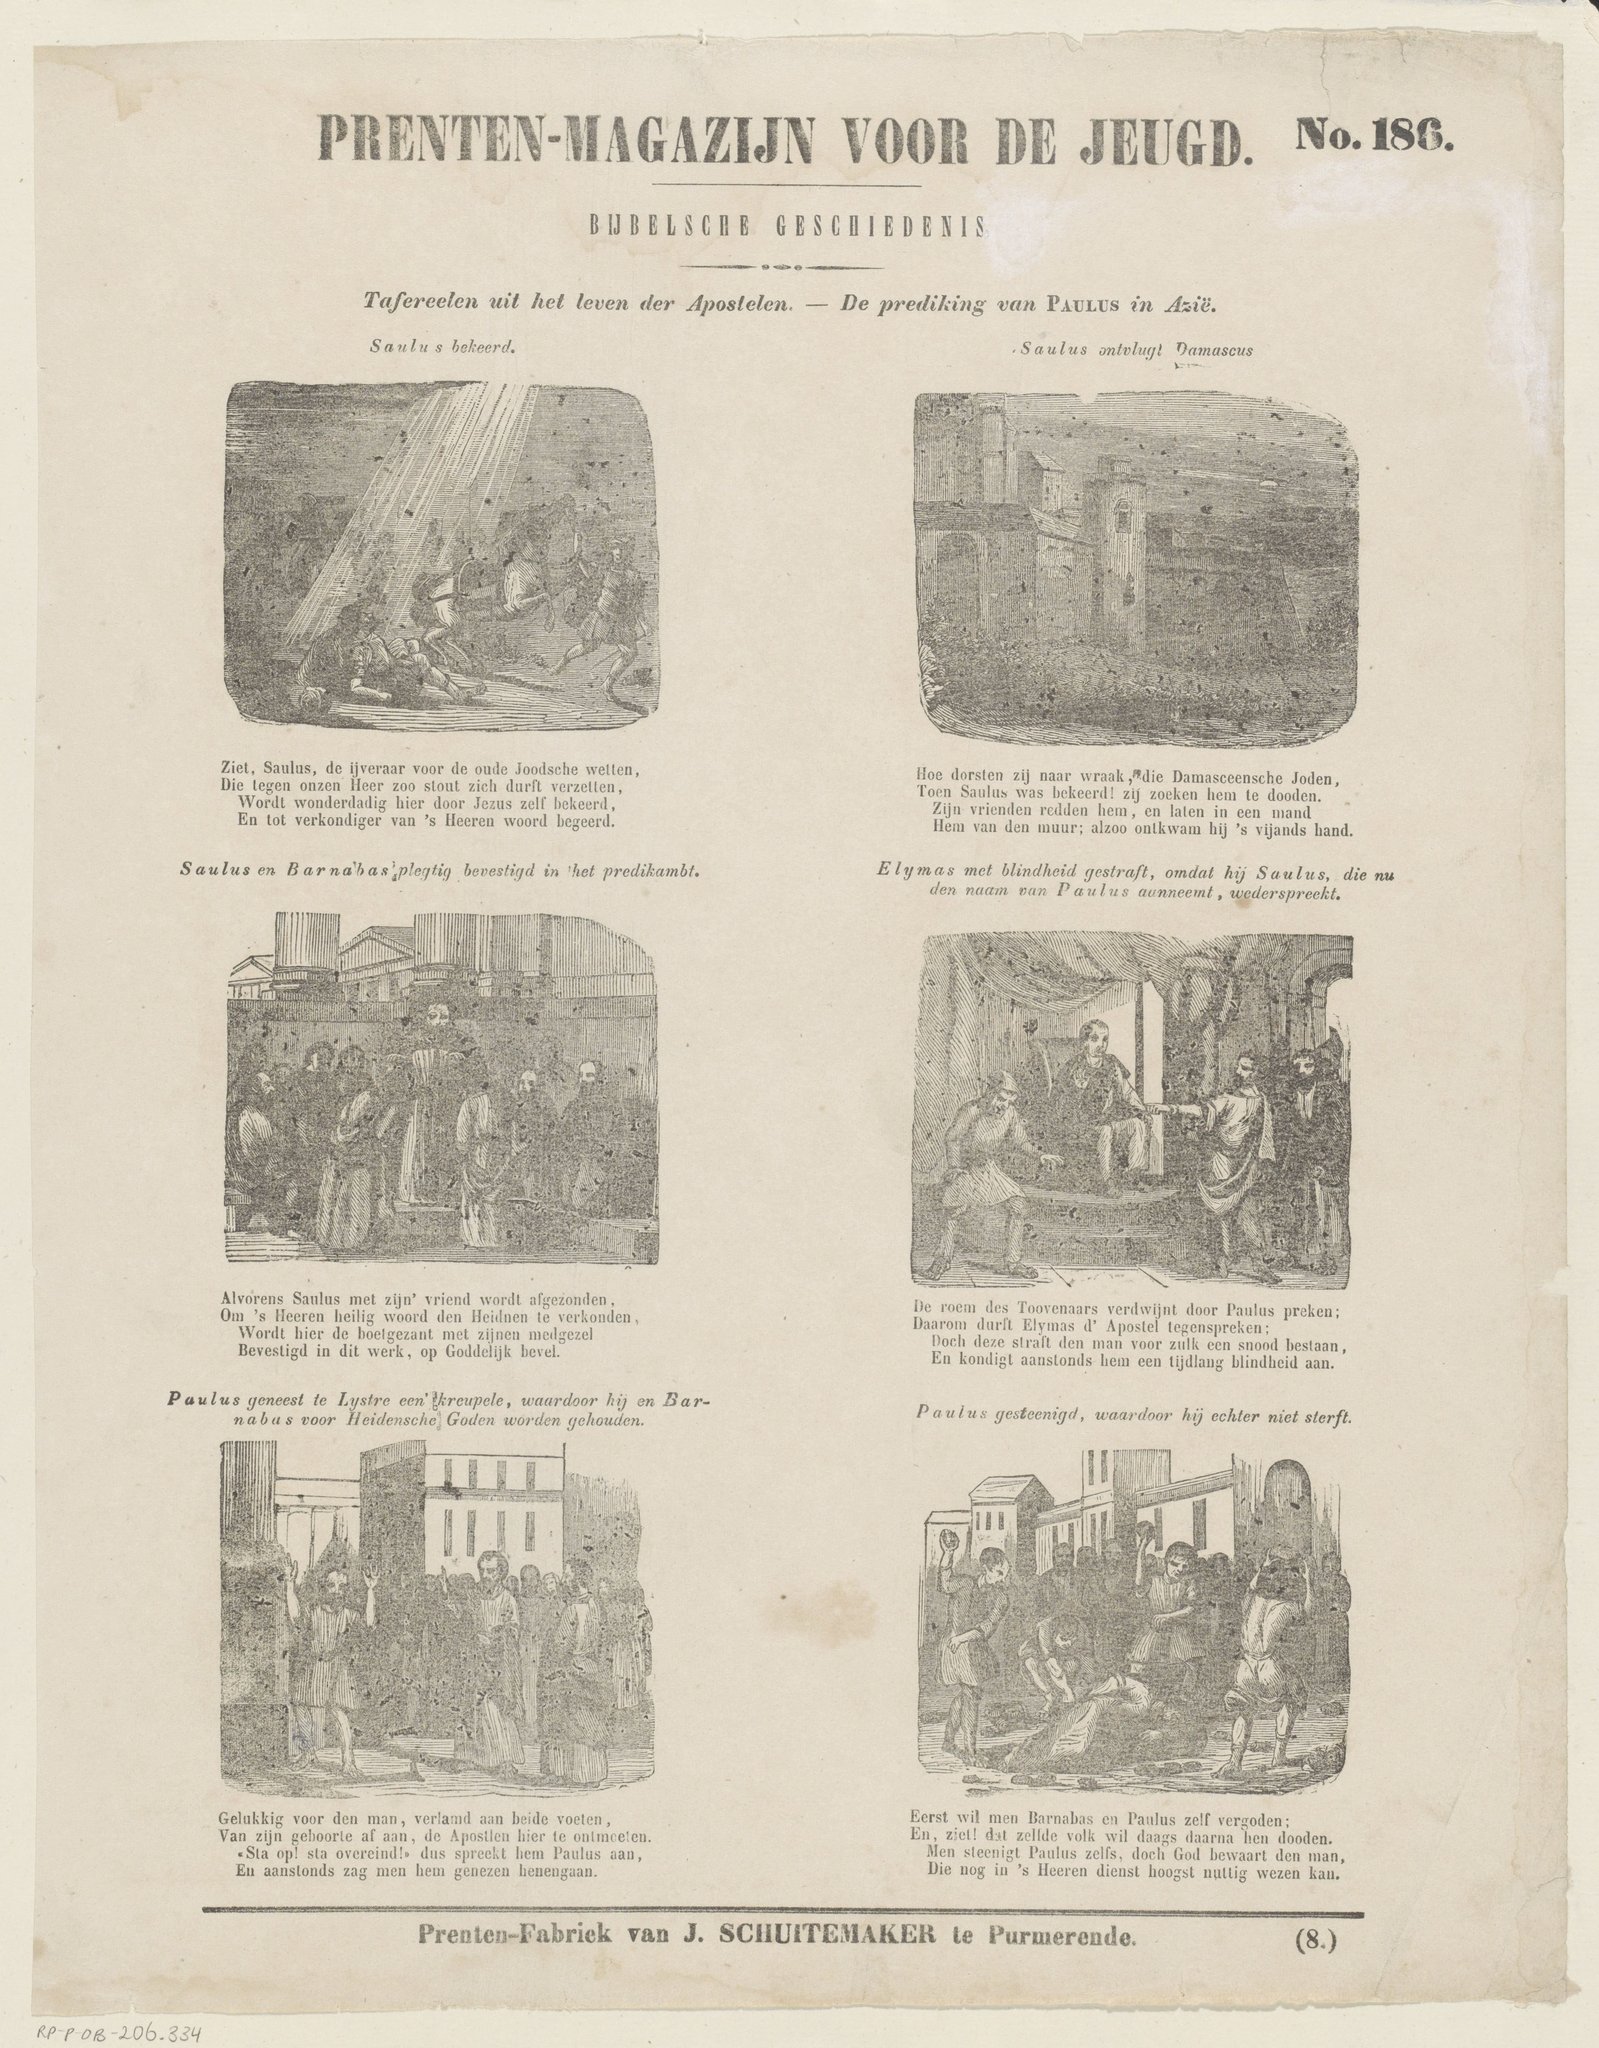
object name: popular print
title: Bijbelsche geschiedenis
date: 1850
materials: paper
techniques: letterpress printing, engraving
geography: purmerend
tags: missionary journeys of paul, specific aspects ~ st. paul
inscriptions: collector's mark: Lugt 2760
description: Na voltooiing van de acht jaargangen van de reeks 'Prenten-magazijn voor de jeugd' in 1850 heeft Jan Schuitemaker al deze prenten heruitgegeven en omgenummerd als nr. 1 t/m 192. De oorspronkelijke jaargang wordt telkens nog vermeld rechtsonder op de prent. Binnen de jaargangen zijn prenten van hetzelfde thema in clusters van vier achter elkaar gezet.